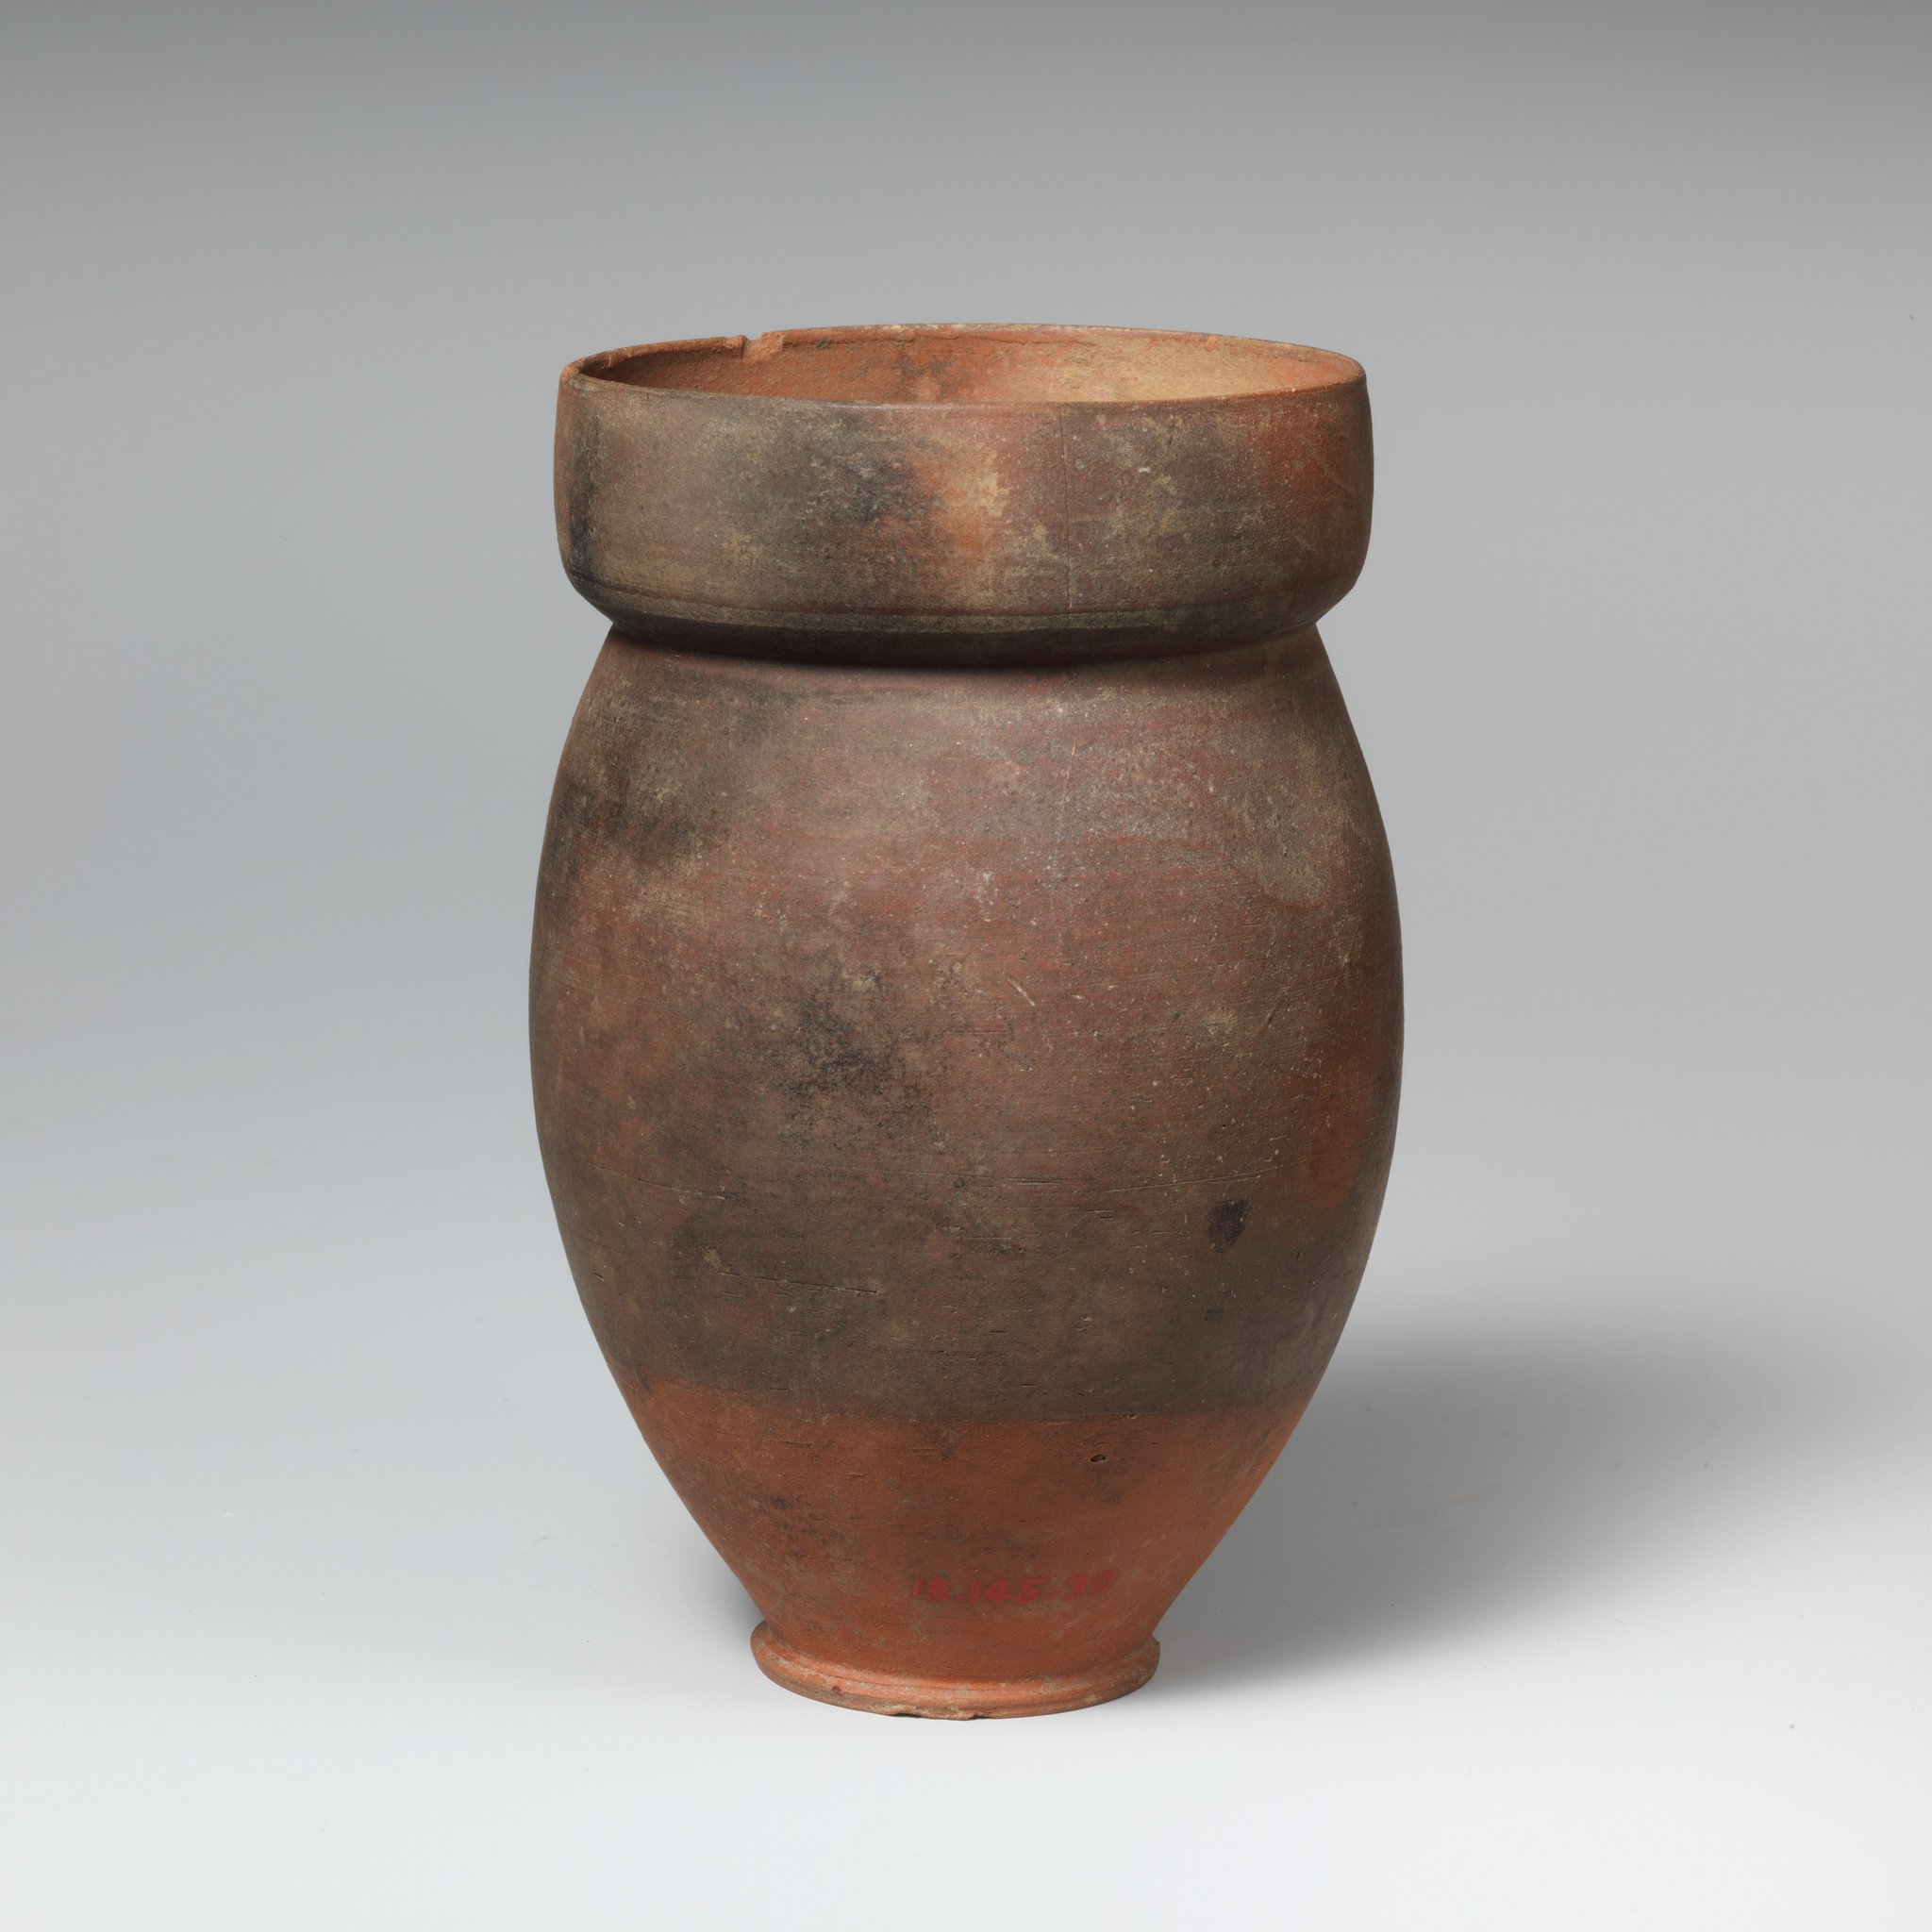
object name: cup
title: Terracotta beaker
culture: roman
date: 34-1 BCE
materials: terracotta